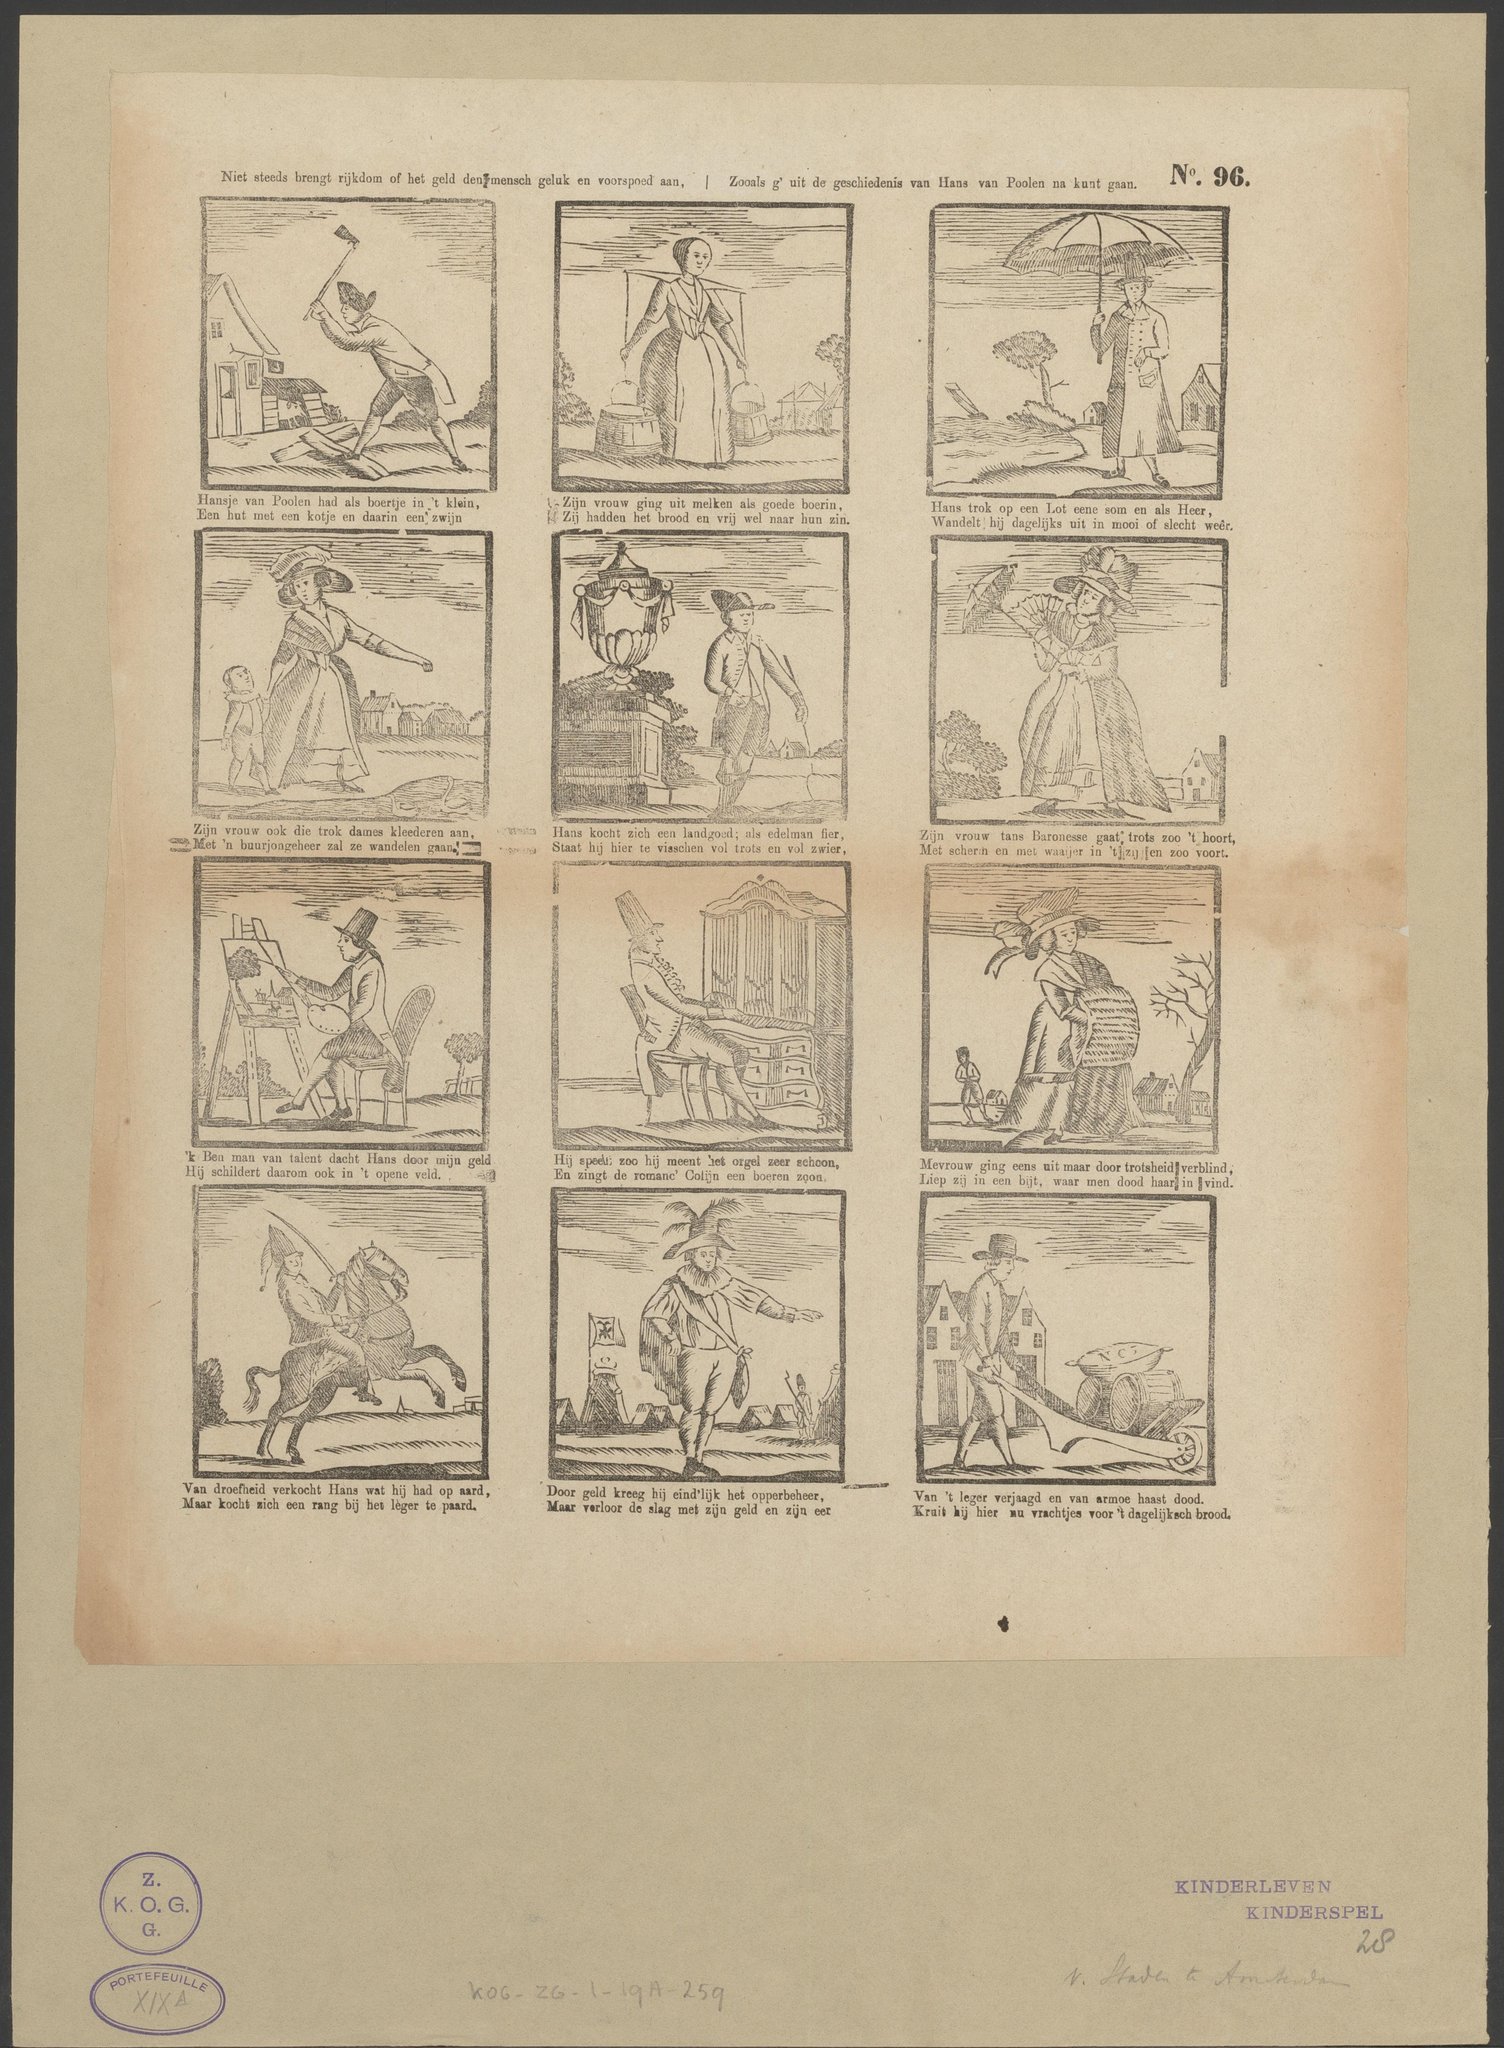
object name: print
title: Leven van Hans van Polen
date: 1850-1870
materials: paper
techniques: letterpress printing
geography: amsterdam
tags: contrast between rich and poor, church organ, warfare; military affairs, tales and fairy tales, milkmaid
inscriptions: collector's mark: Lugt 1641, stamp, stamp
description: Blad met 12 voorstellingen uit het leven van Hans van Polen. Onder elke afbeelding een tweeregelig vers. Genummerd rechtsboven: No. 96. Onderwerpsrubrieken binnen de Atlas Zeden en Gewoonten: Zeden en Gewoonten in Engeren Zin, Des menschen beging, midden en einde, Kinderleven – Kinderspel en Kinderprenten.